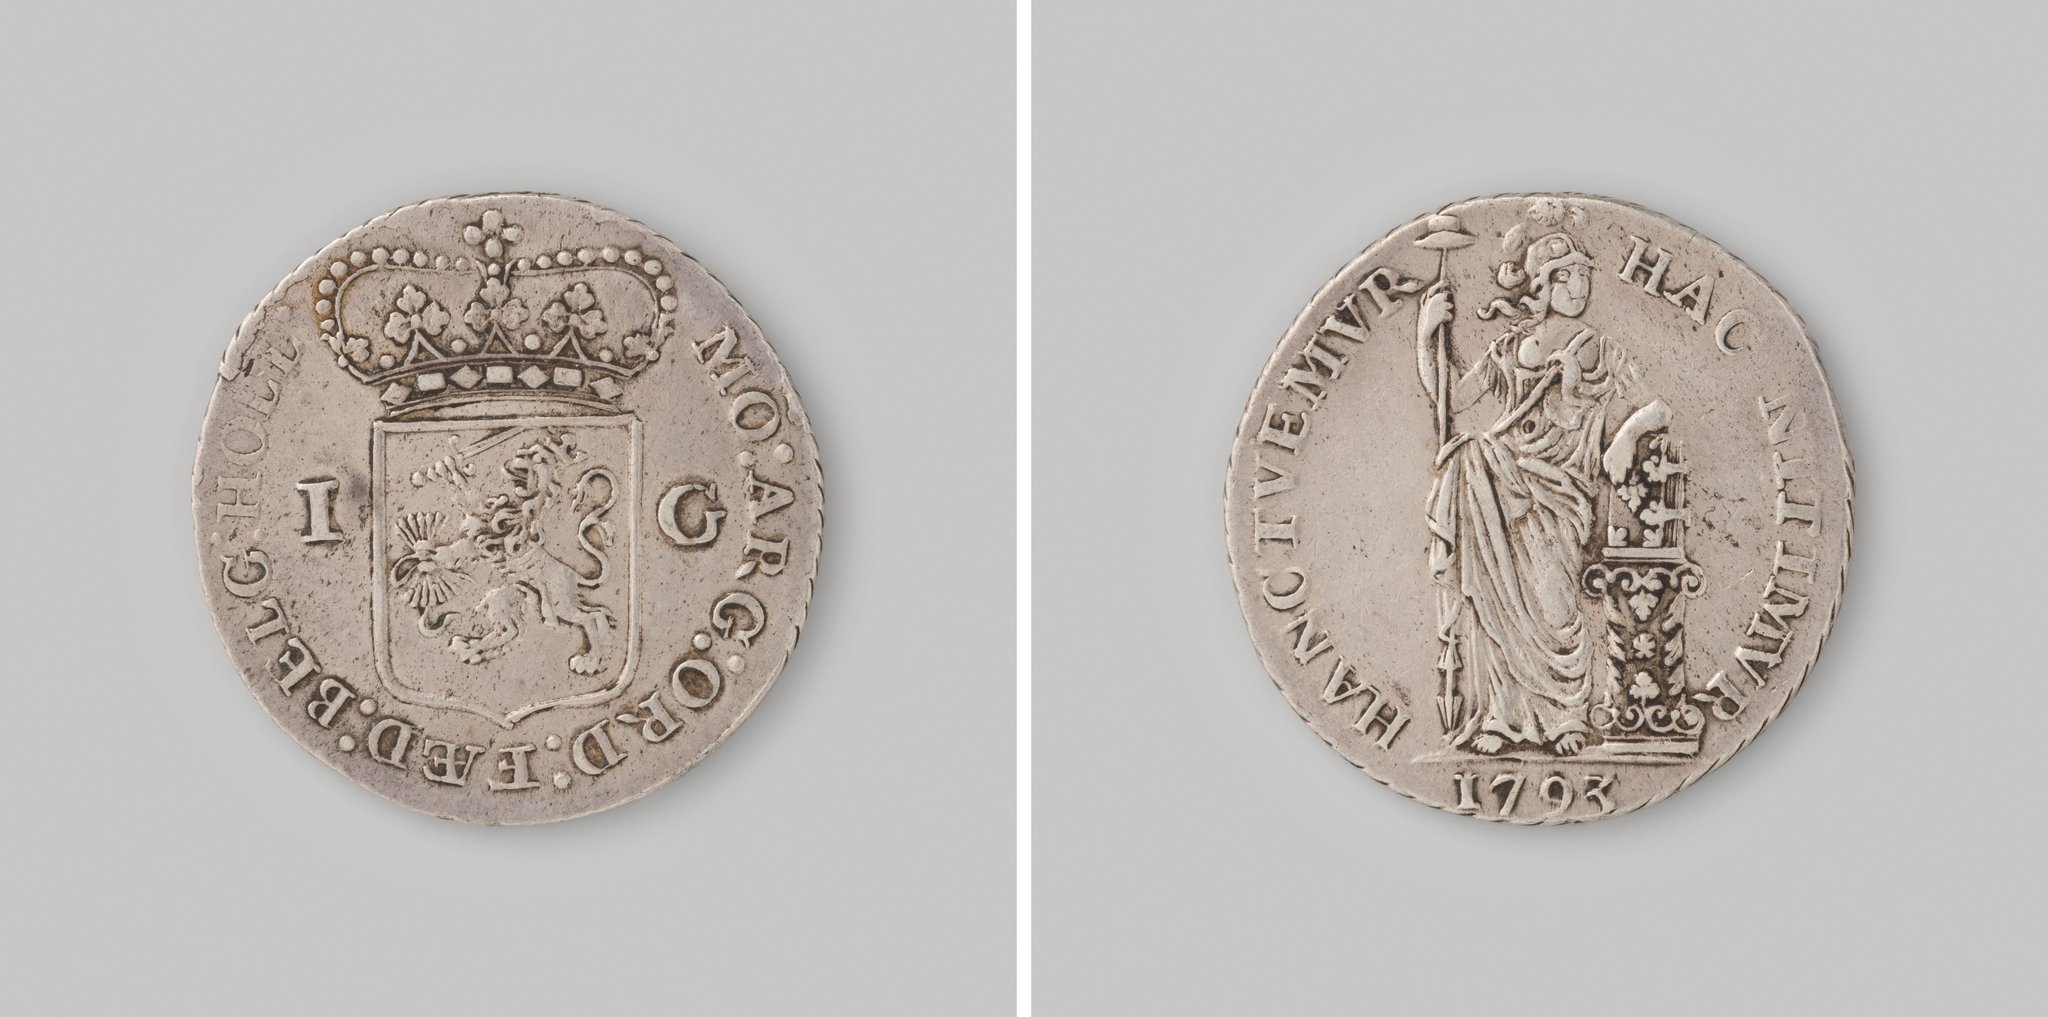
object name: coin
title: Holland, gulden, 1793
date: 1793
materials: silver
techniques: striking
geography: dordrecht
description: Zilveren munt. Voorzijde: tussen waarde-aanduiding gekroond generaliteitswapenschild. Keerzijde: staande Nederlandse maagd met in rechterhand speer, waarop hoed en met linkerhand steunend op altaar, waarop bijlbel. In afsnede jaartal. Kabelrand.